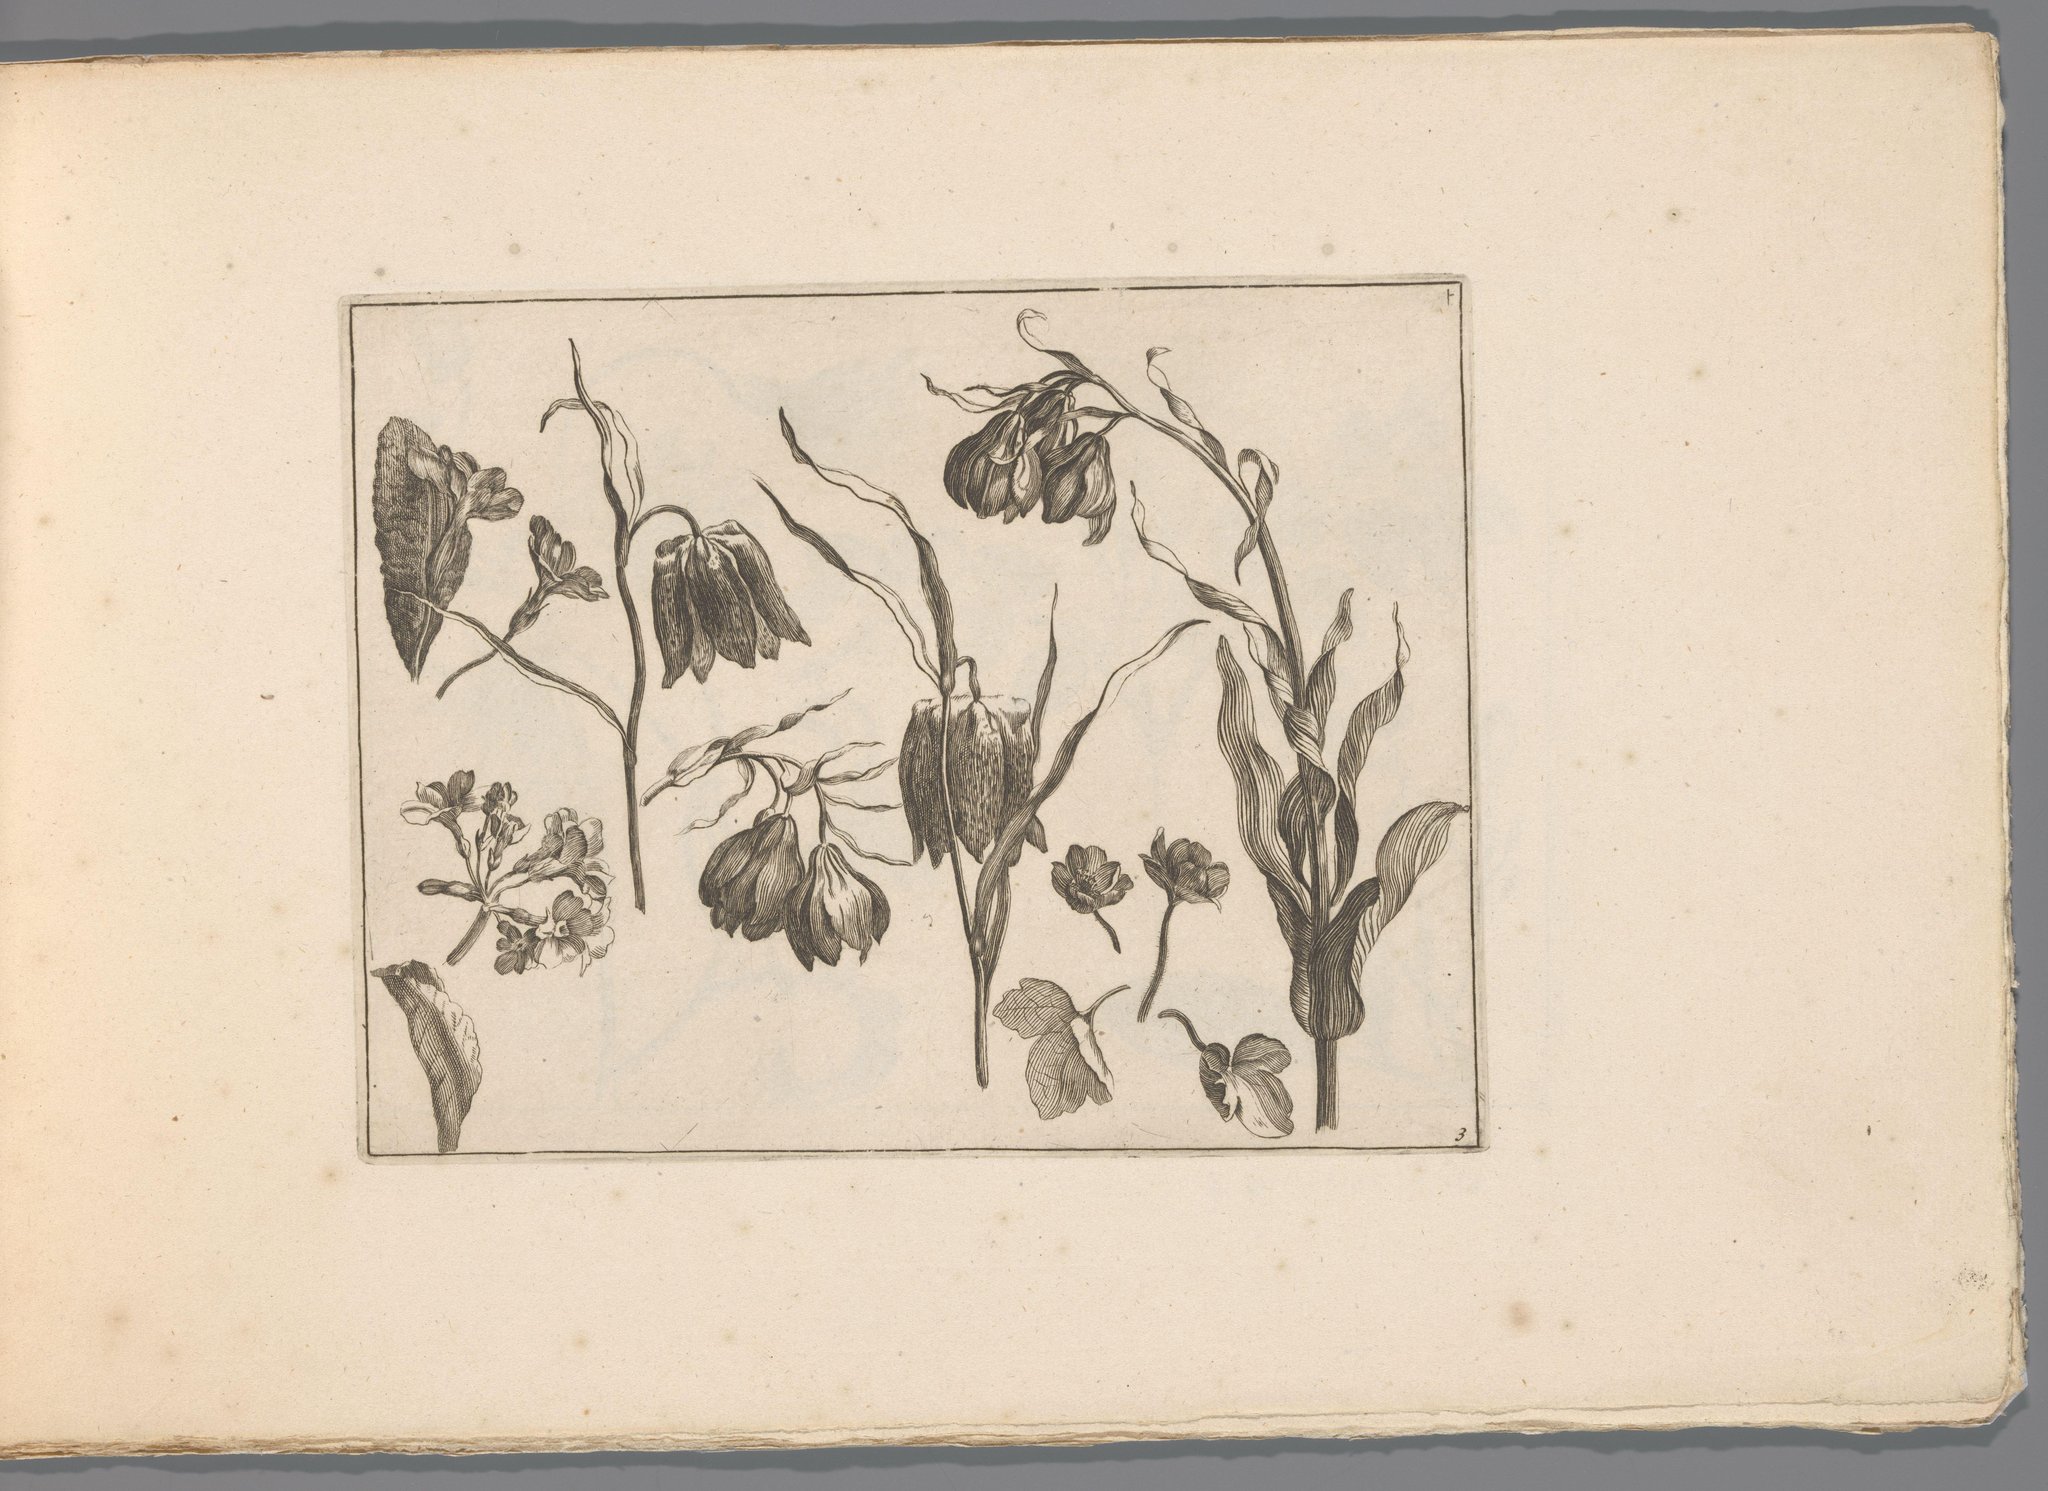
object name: ornament print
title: Verschillende bloemen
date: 1670-1726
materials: paper, fiber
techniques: engraving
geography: amsterdam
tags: flowers: bell-flower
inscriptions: collector's mark: Lugt 2228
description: De prent maakt deel uit van een samengebonden, genummerde serie van elf prenten met bloemen. De serie bestond oorspronkelijk waarschijnlijk uit twaalf prenten. Het fonds- of serienummer is nr. 60.